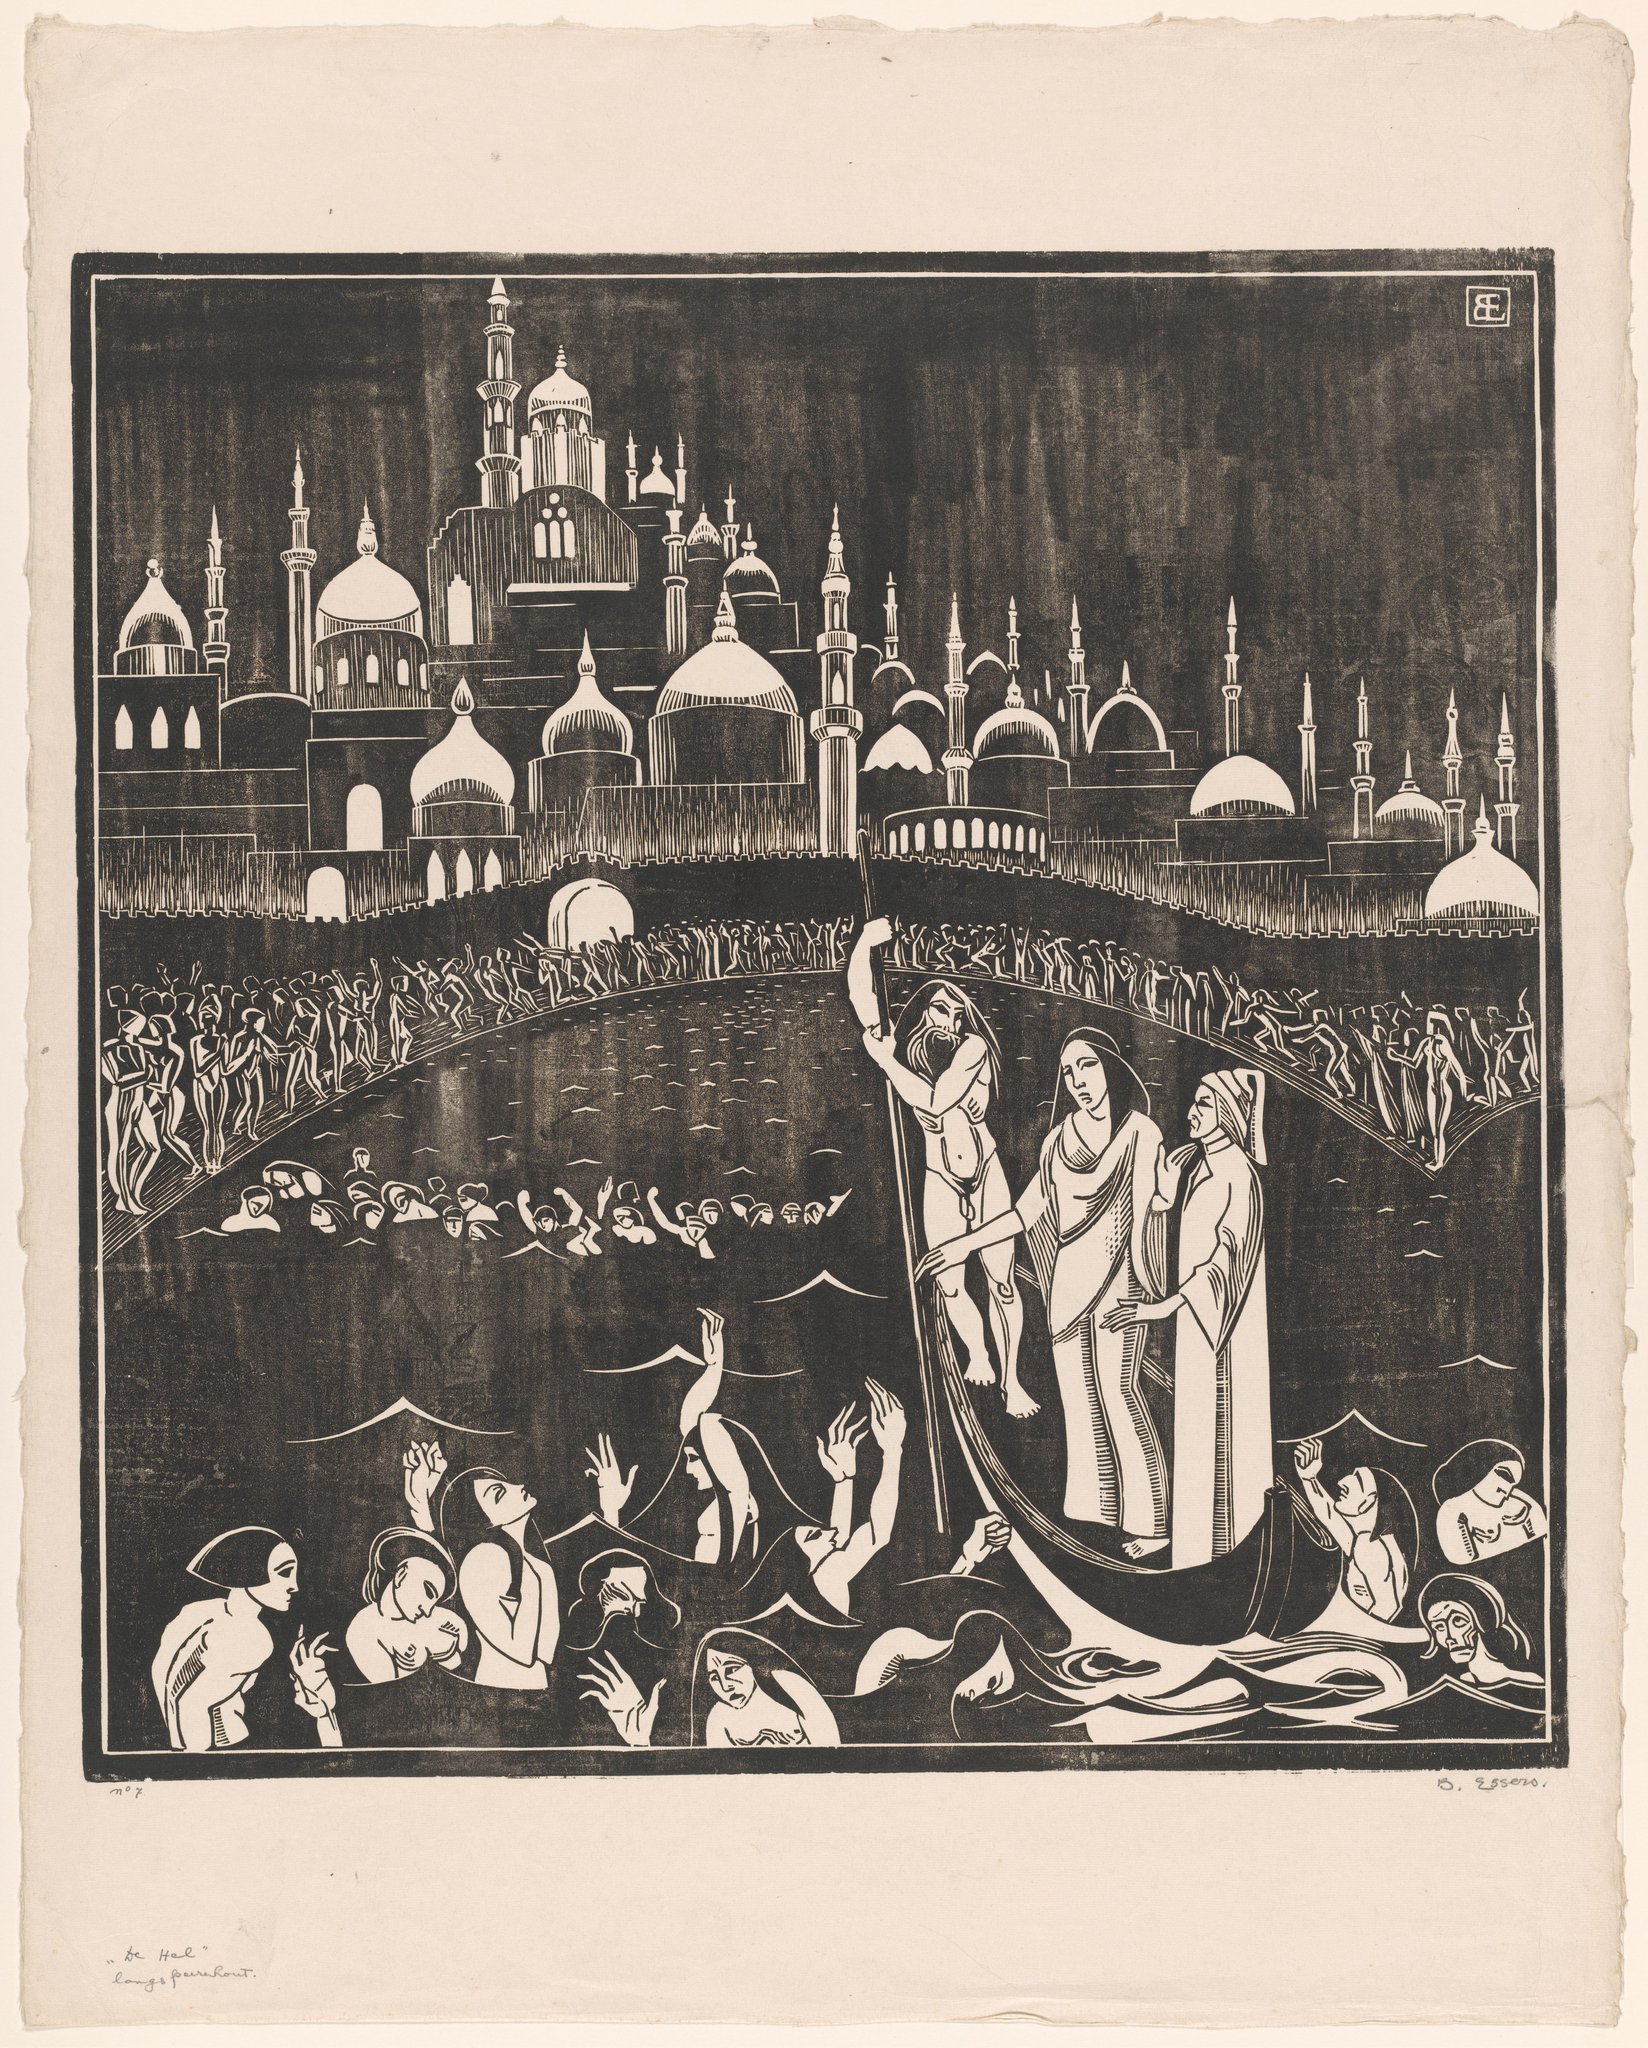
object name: print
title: De Hel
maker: bernard essers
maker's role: print maker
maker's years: 1893-1945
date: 1922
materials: paper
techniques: woodcut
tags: the damned souls, and their punishment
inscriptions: inscription: ‘langs [...]hout’, inscription: ‘No. 7’, collector's mark: Lugt 2228